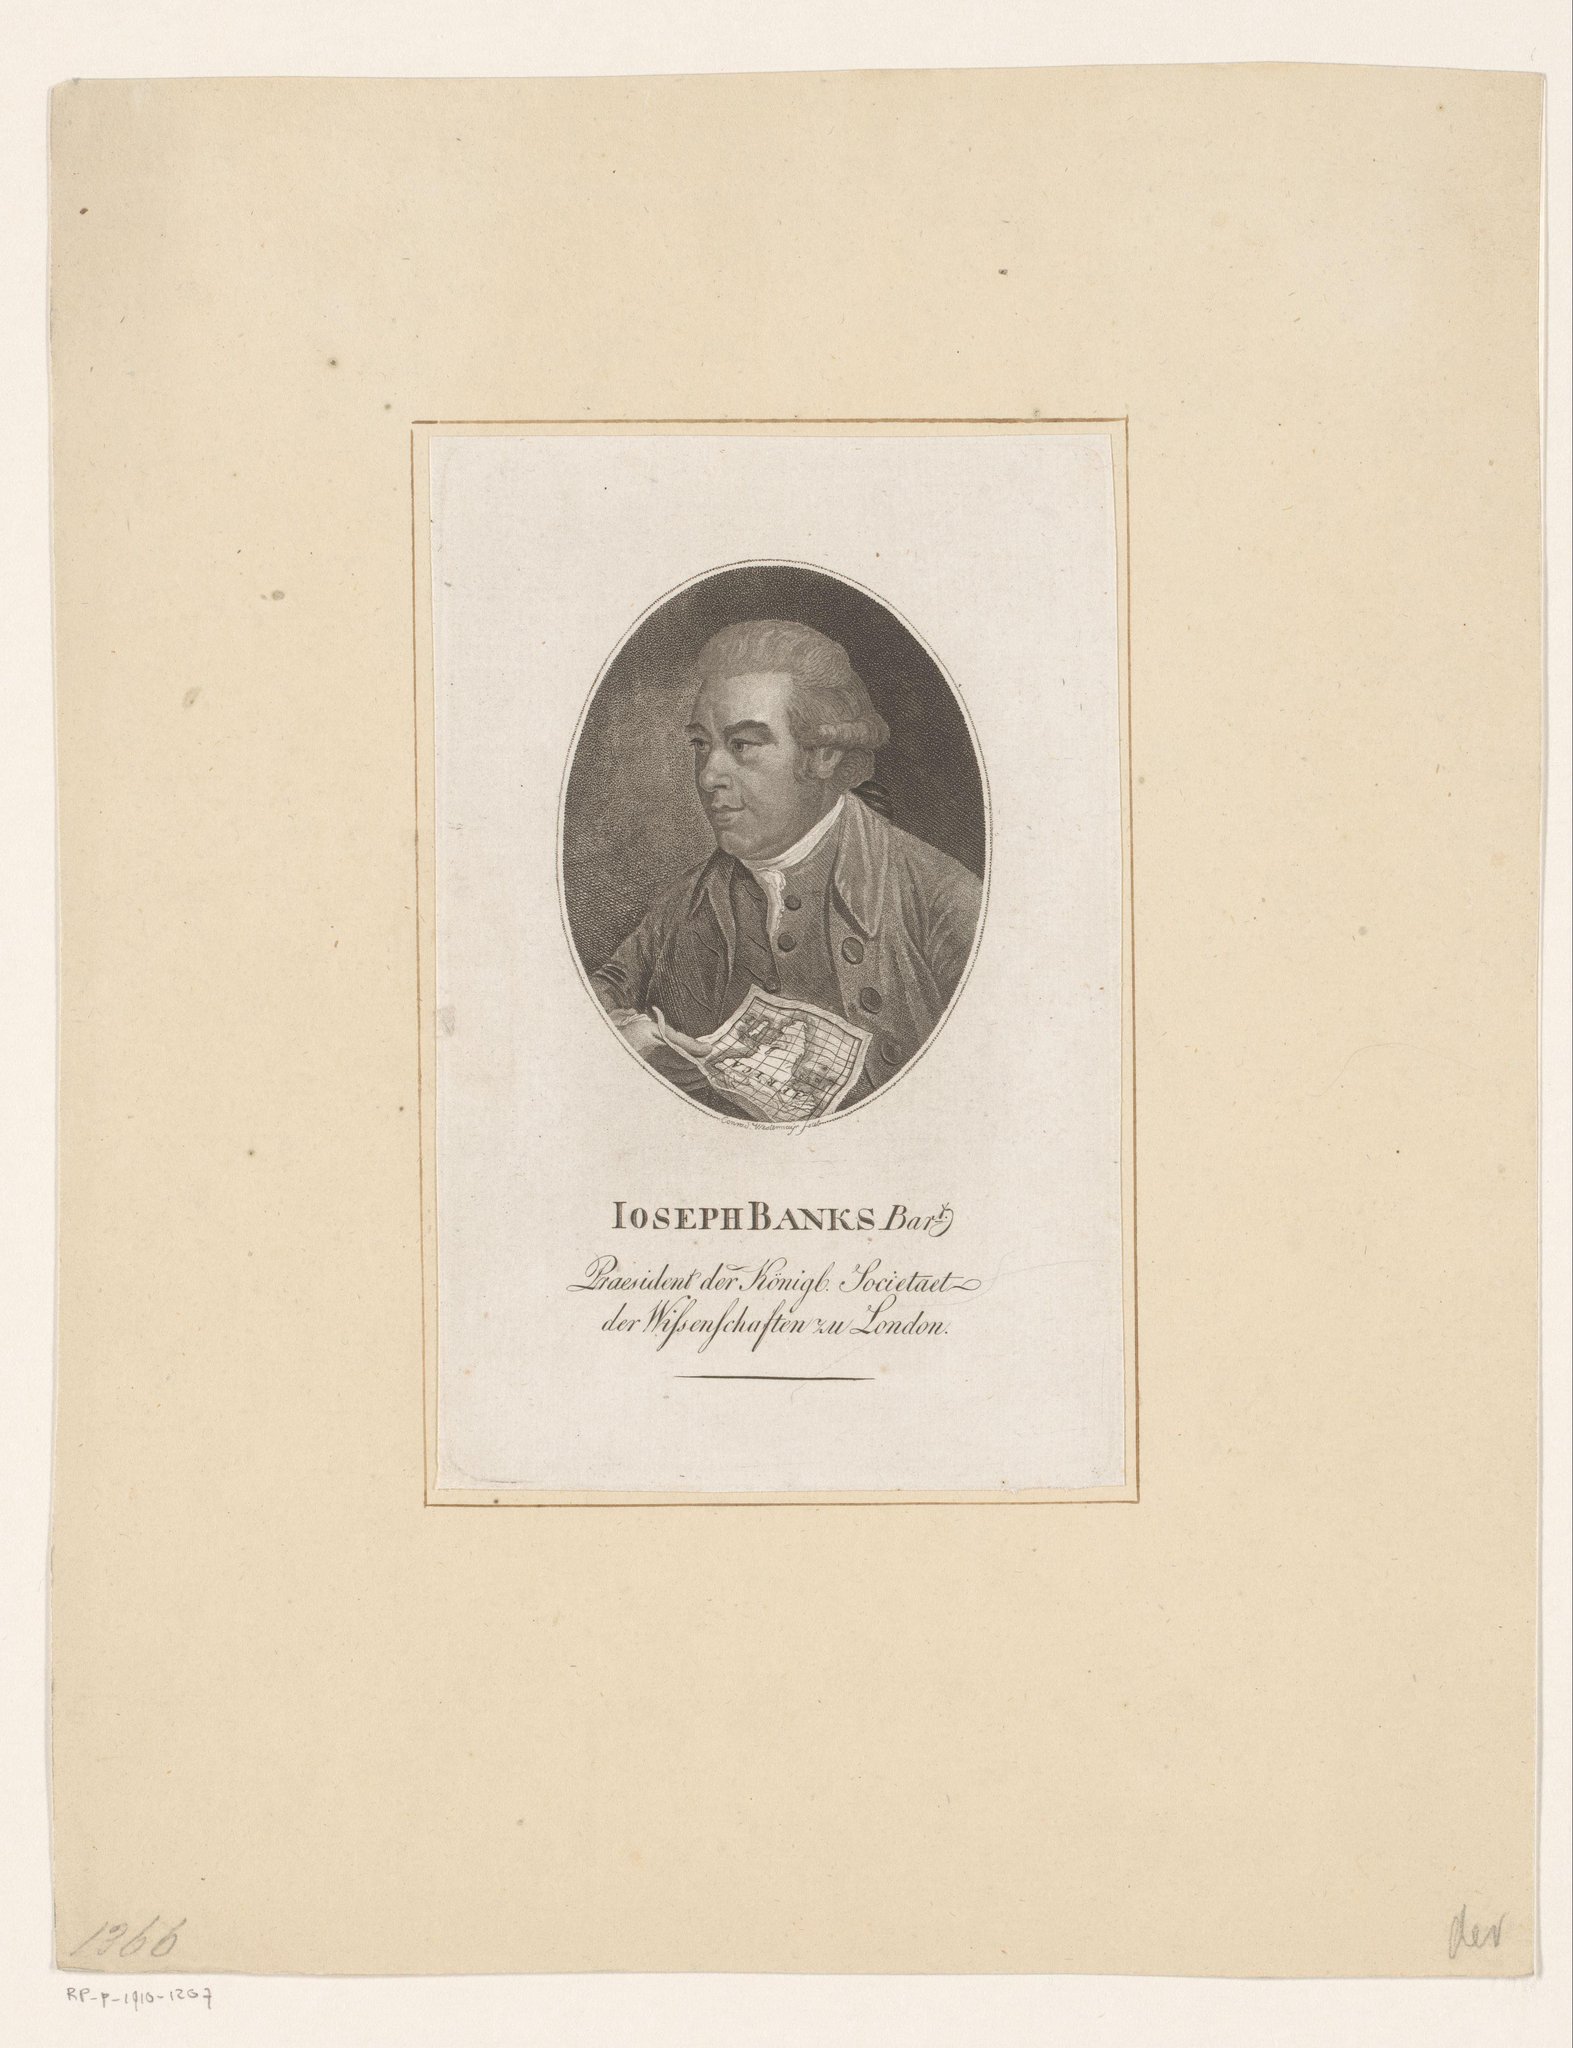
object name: print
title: Portret van Sir Joseph Banks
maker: konrad westermayr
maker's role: print maker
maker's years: 1765-1834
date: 1775-1834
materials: paper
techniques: engraving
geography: germany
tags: joseph banks, (map of) africa, historical persons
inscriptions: collector's mark: Lugt 2228